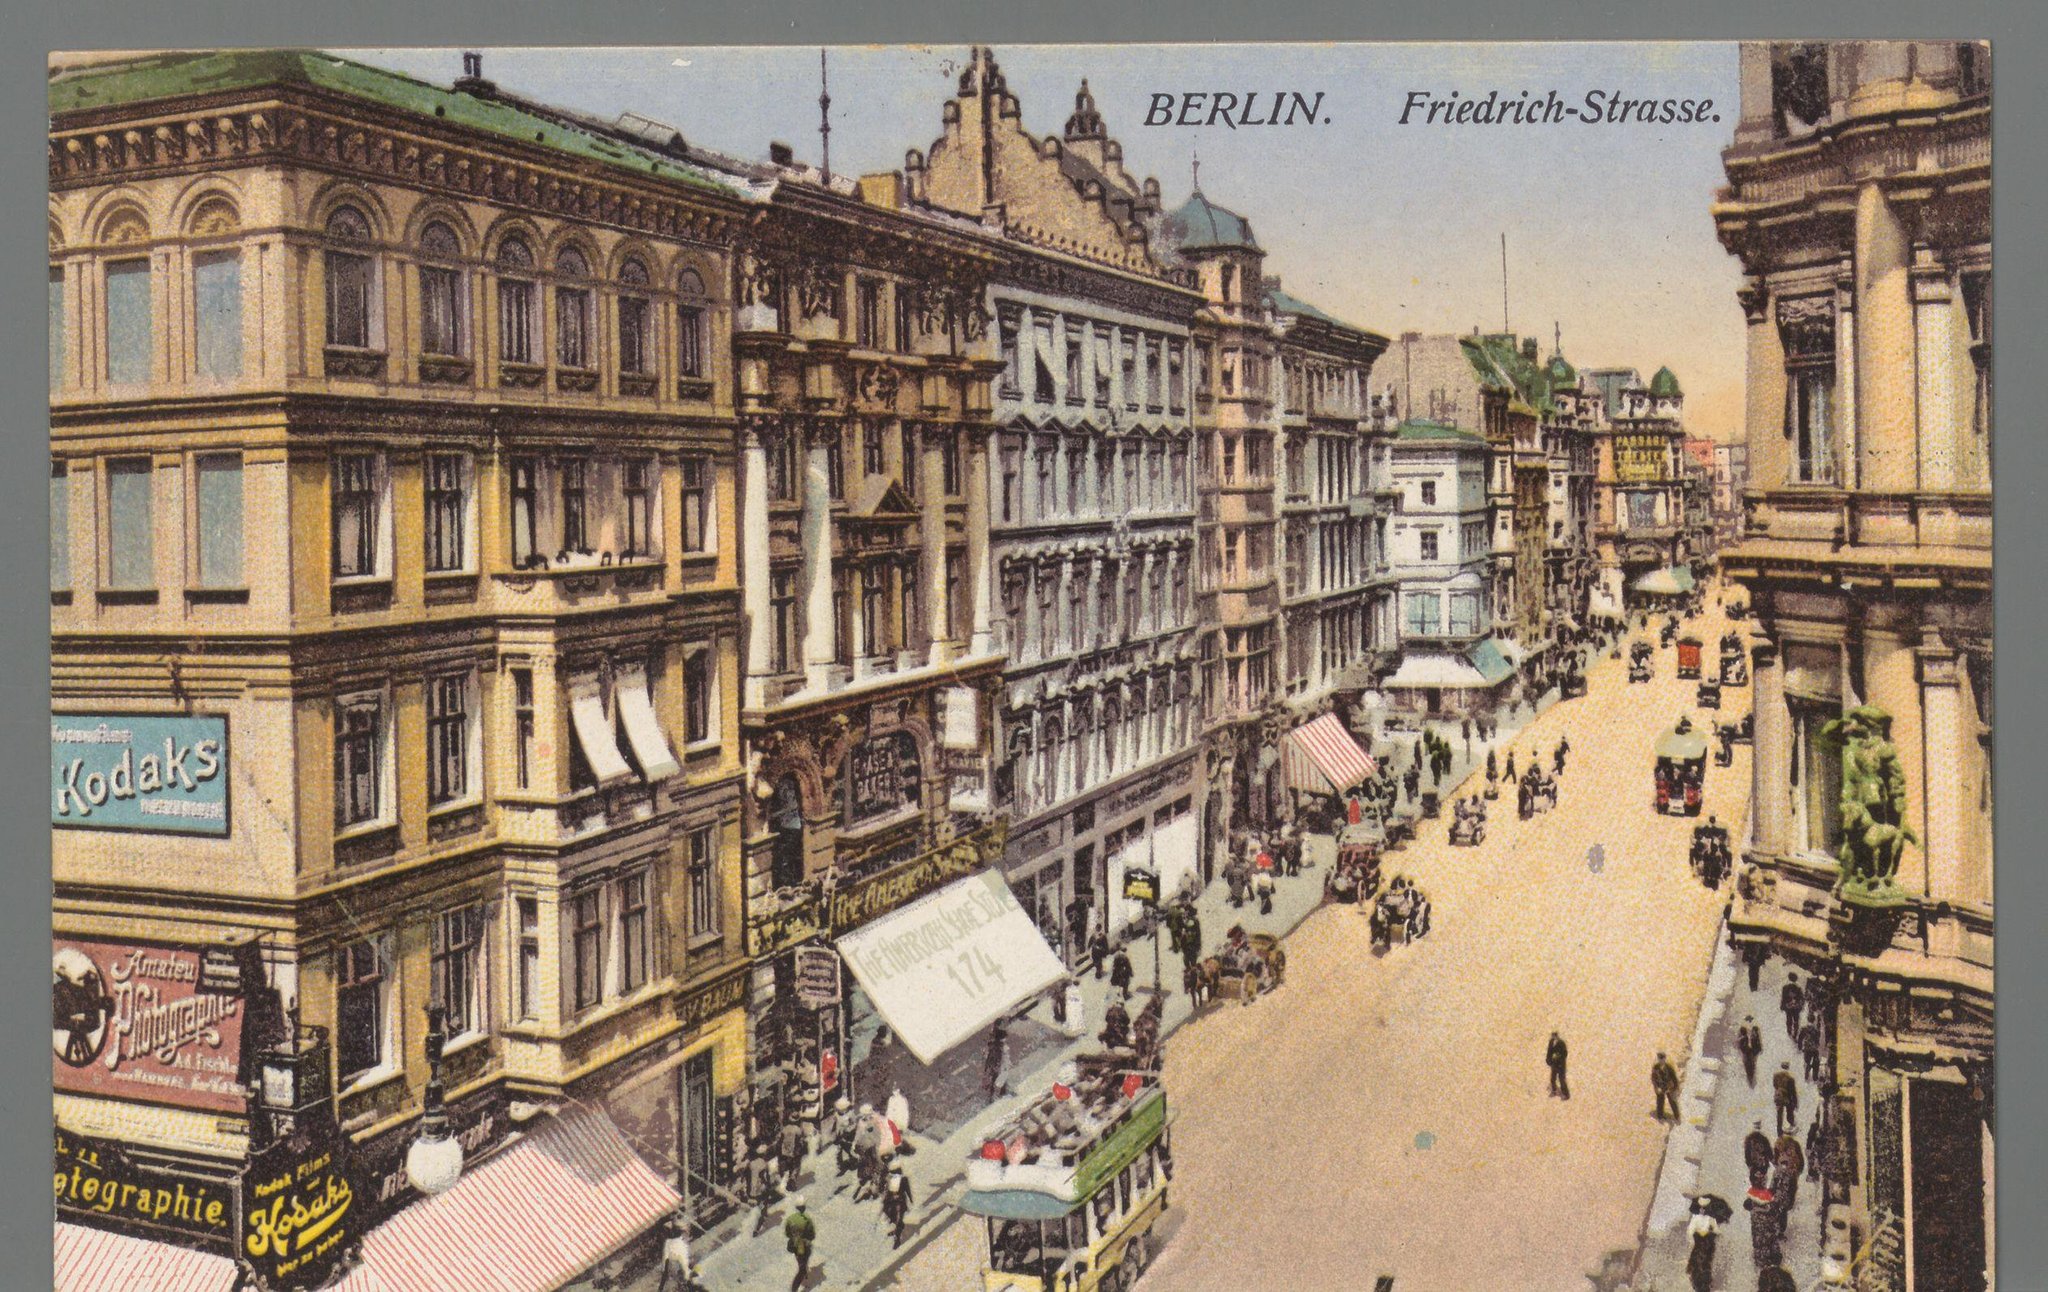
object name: photomechanical print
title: Berlin. Friedrich-Strasse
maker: Anonymous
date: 1905-1930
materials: cardboard, photographic process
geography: berlin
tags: shop, store, street